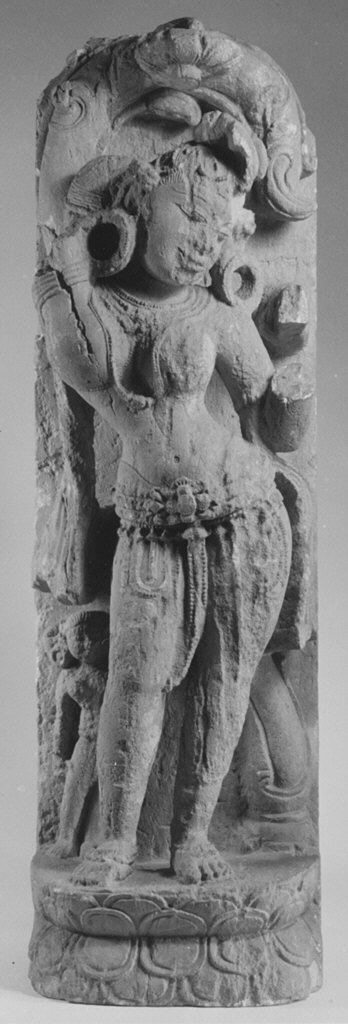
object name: figure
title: Preening Celestial Deity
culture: indian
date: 1001-1200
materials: stone